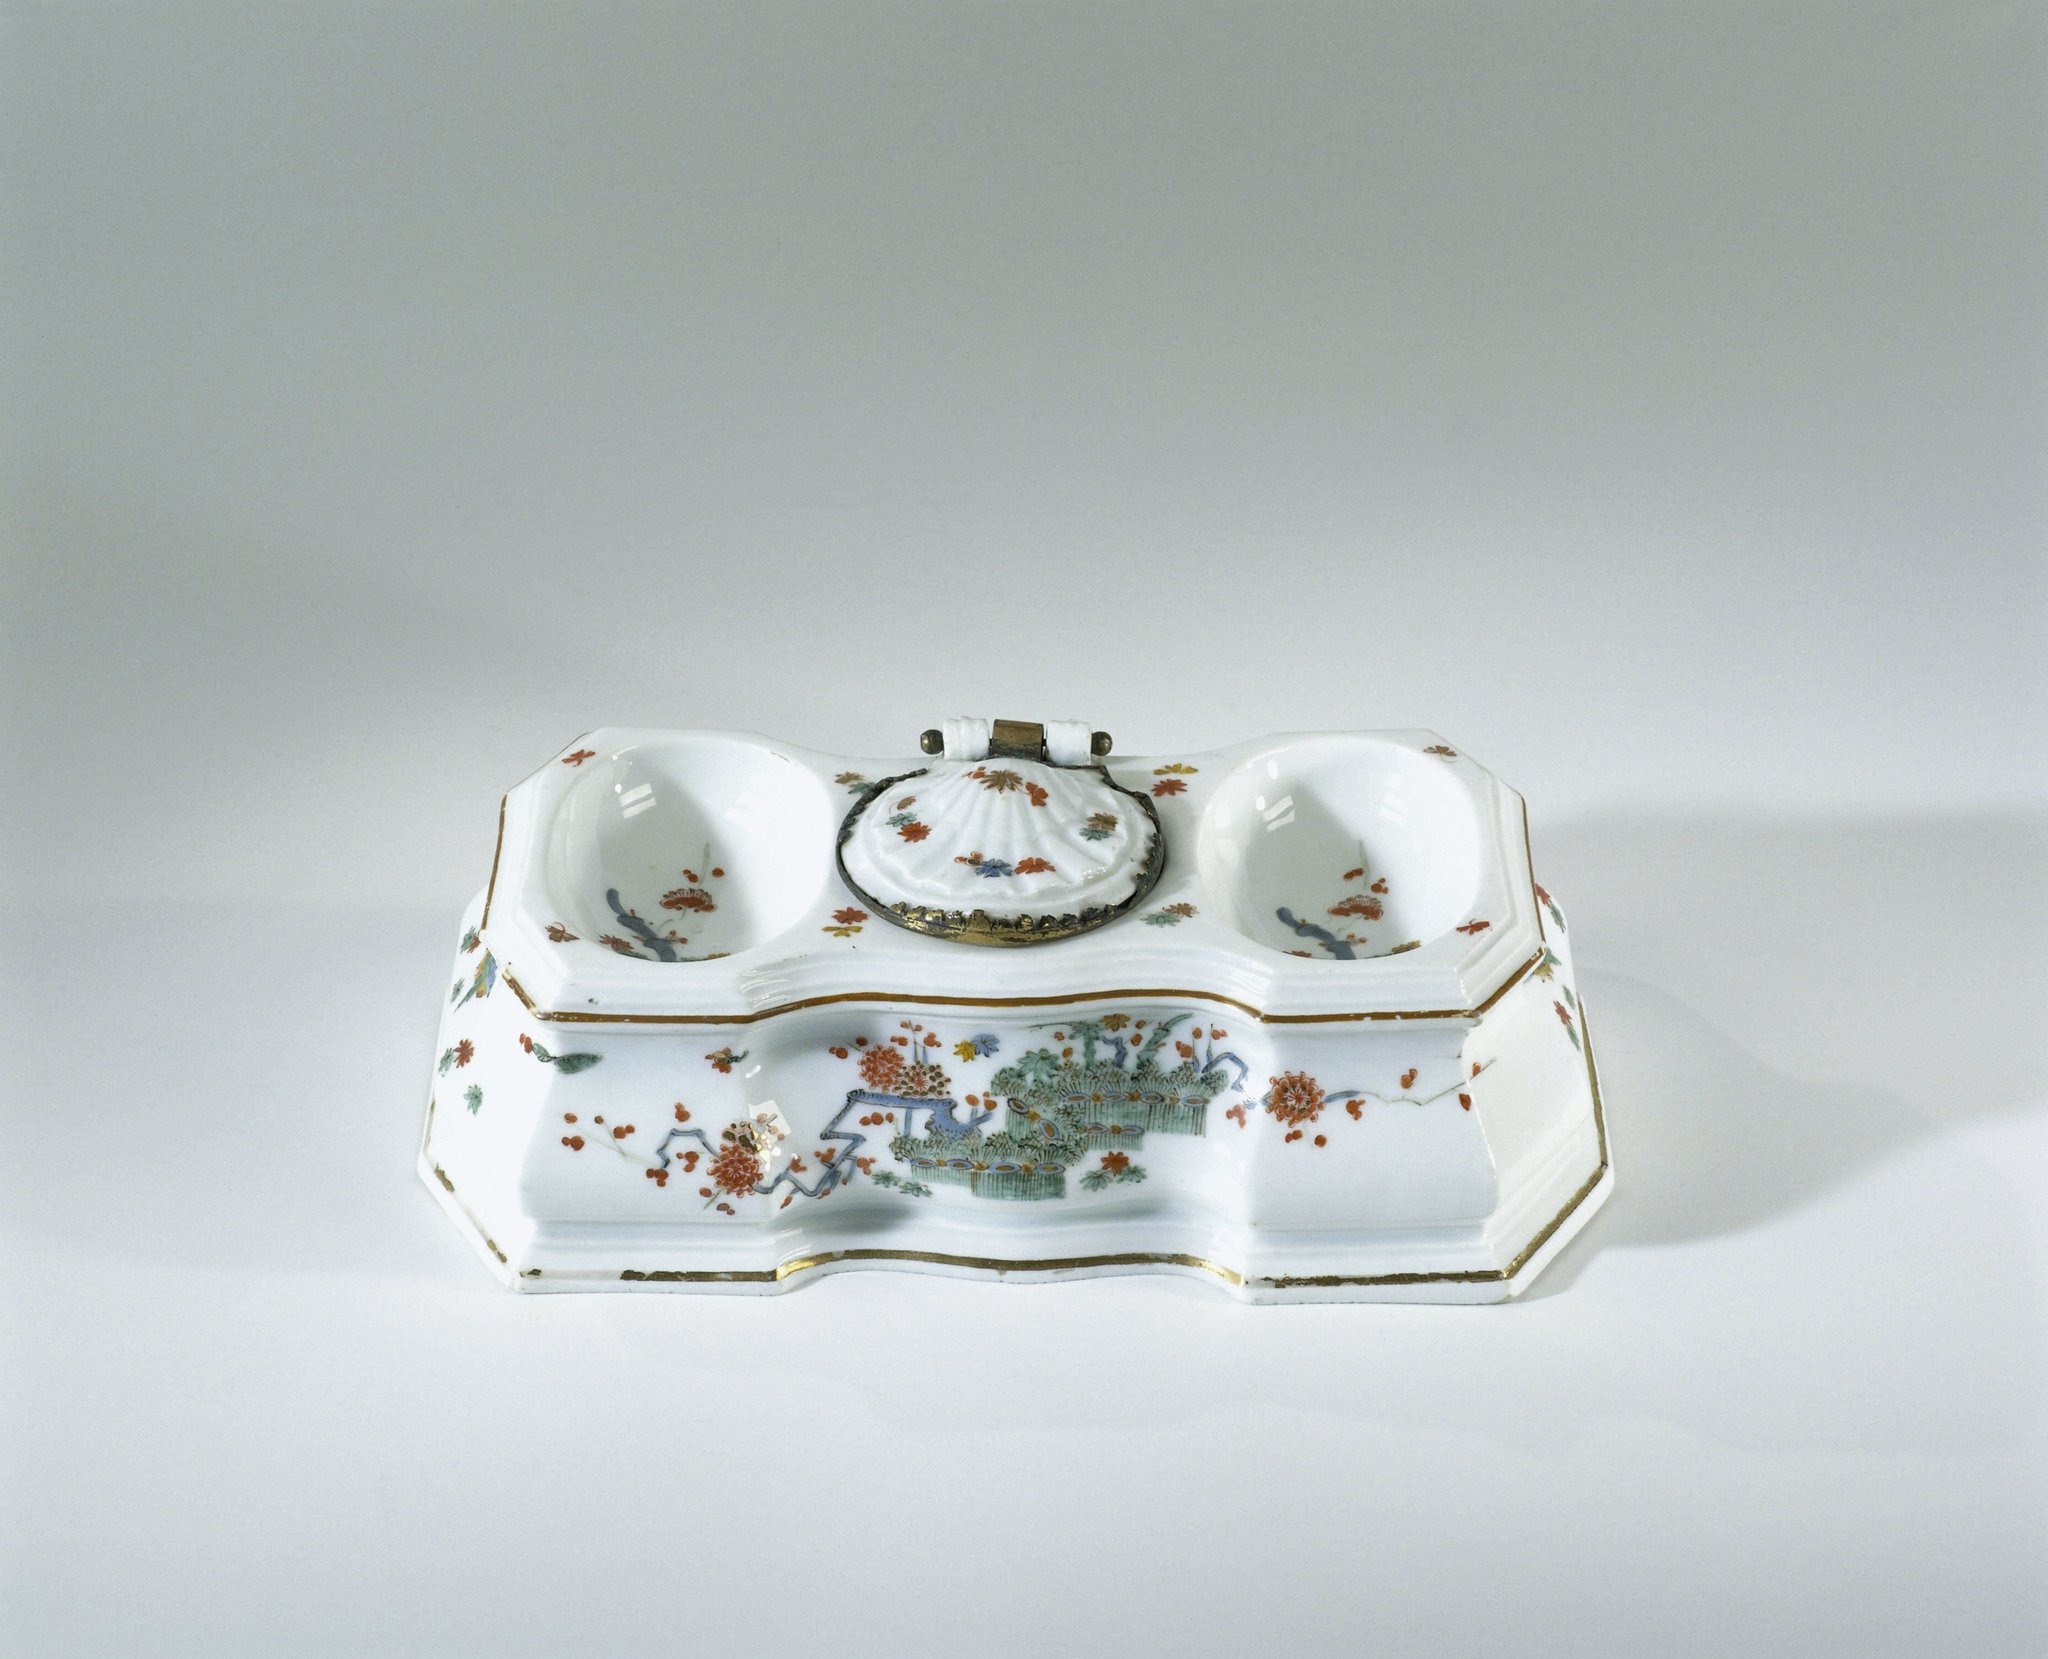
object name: kruidendoos, specerijdoos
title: Specerijendoos, veelkleurig beschilderd met een Kakiemon-decor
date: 1735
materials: copper, porcelain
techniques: painted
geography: meissen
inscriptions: factory mark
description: Cruet. Porcelain. Meissen, c. 1735.